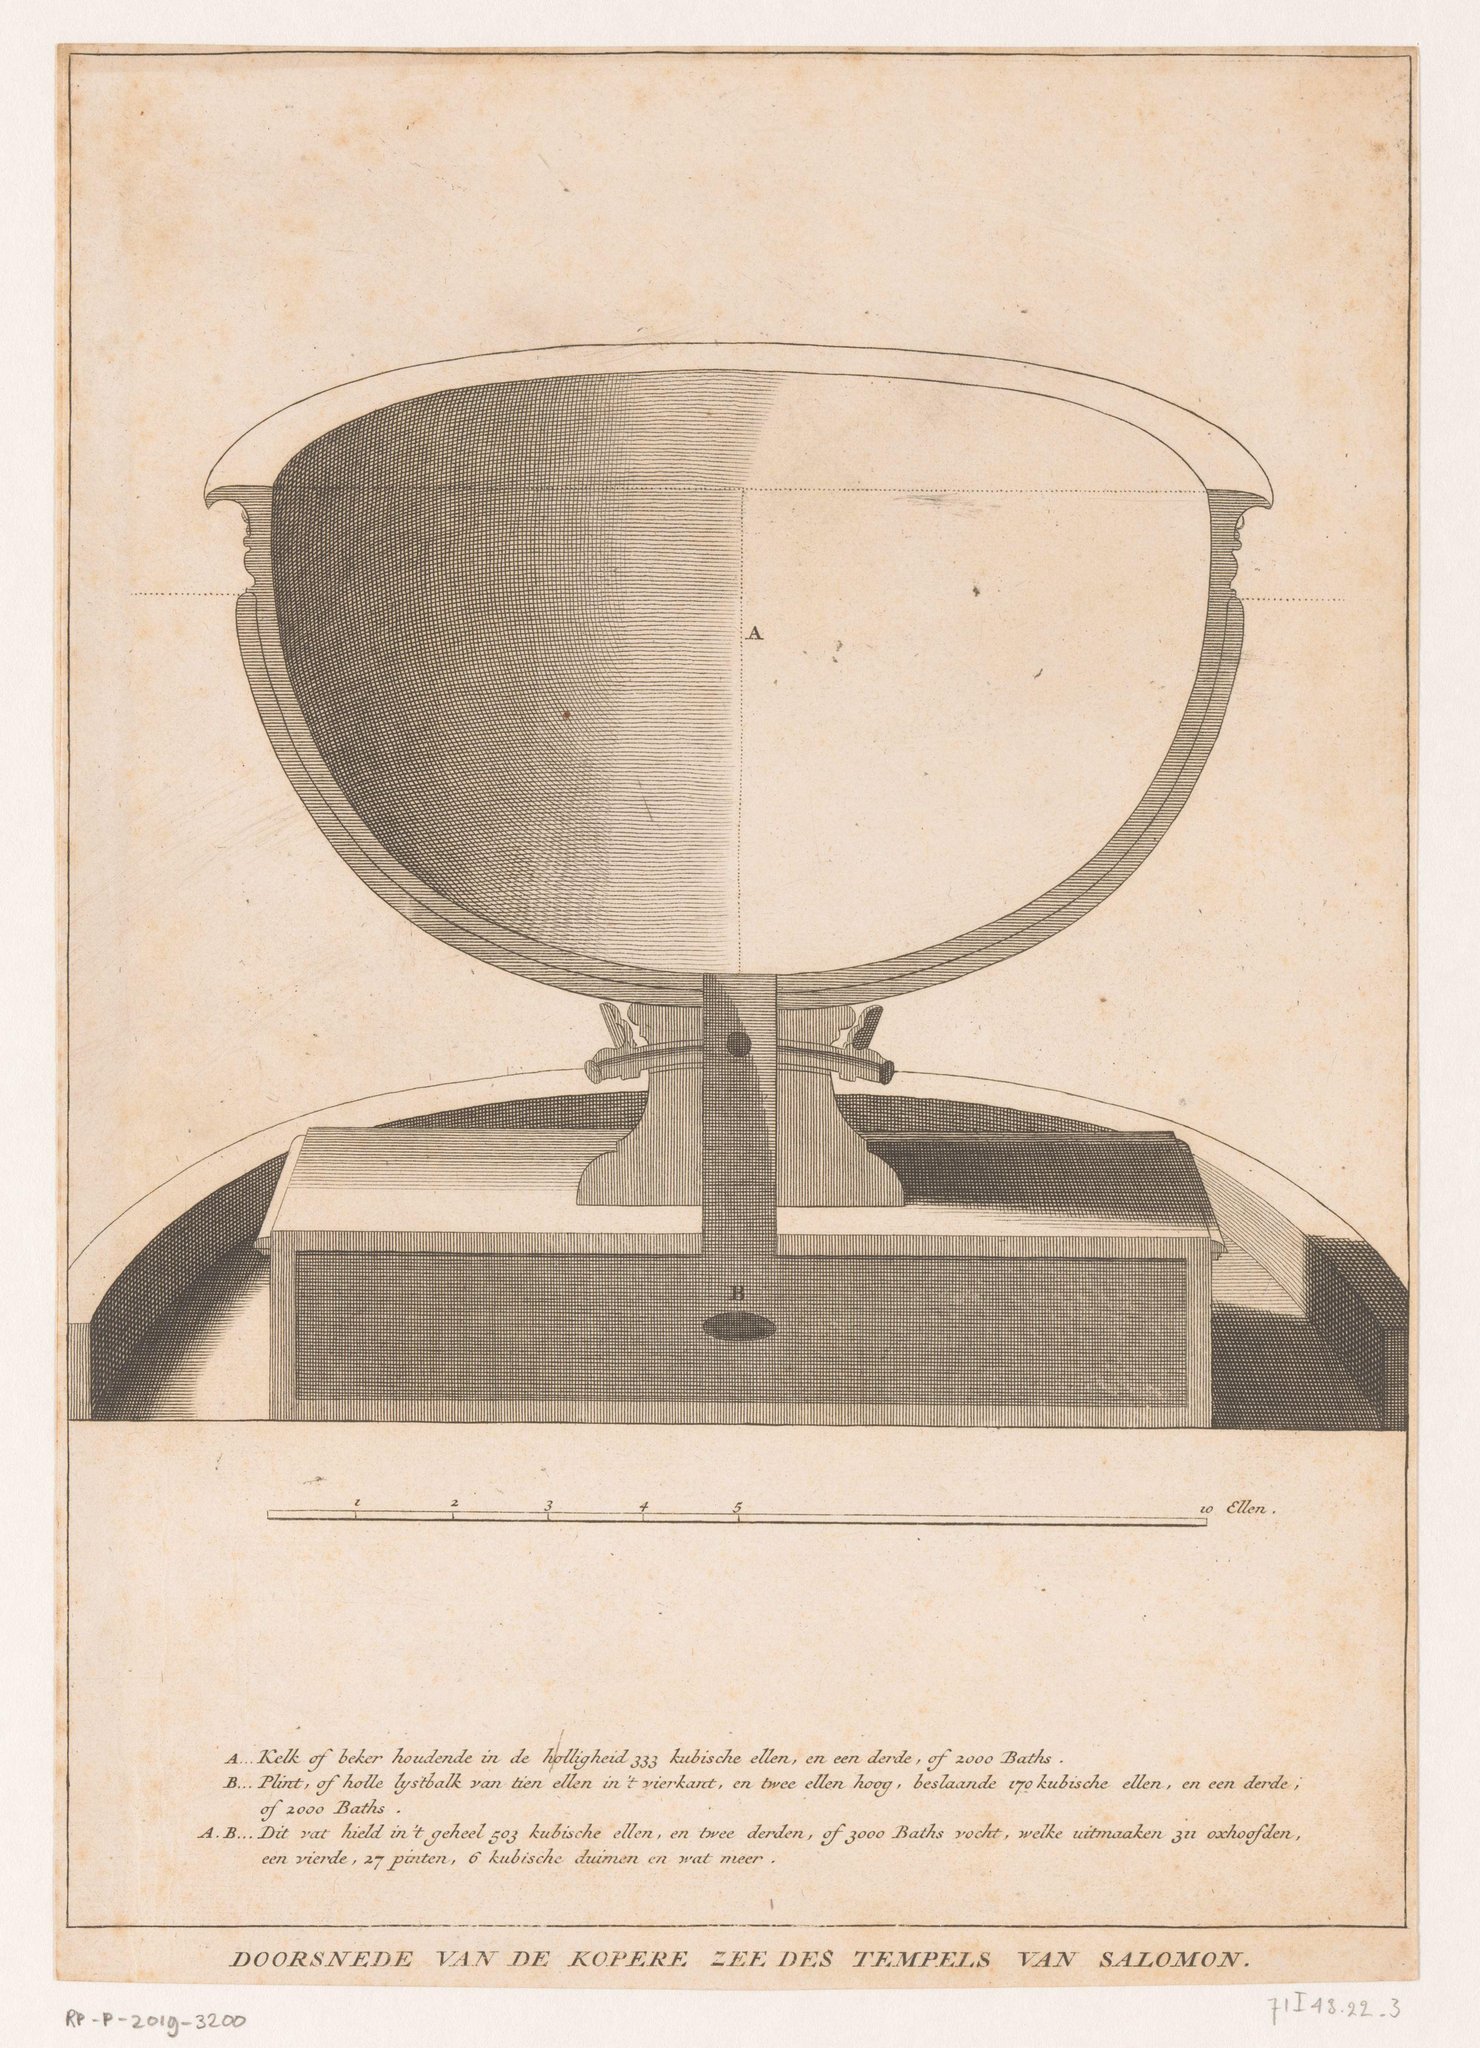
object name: book illustration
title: Koperen Zee uit de tempel van Salomon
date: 1725-1731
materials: paper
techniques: engraving, etching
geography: netherlands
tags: the molten sea, with twelve oxen or lions ~ temple of solomon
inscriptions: collector's mark: Lugt 2228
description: Prent gebruikt voor: Calmet, Augustin. Het algemeen groot historisch, oordeelkundig, chronologisch, geografisch en letterlyk naam- en woord-boek van den gantschen H. Bybel. Amsterdam: R. en J. Wetstein en W. Smith, Leiden: S. Luchtmans, 1725-1731.